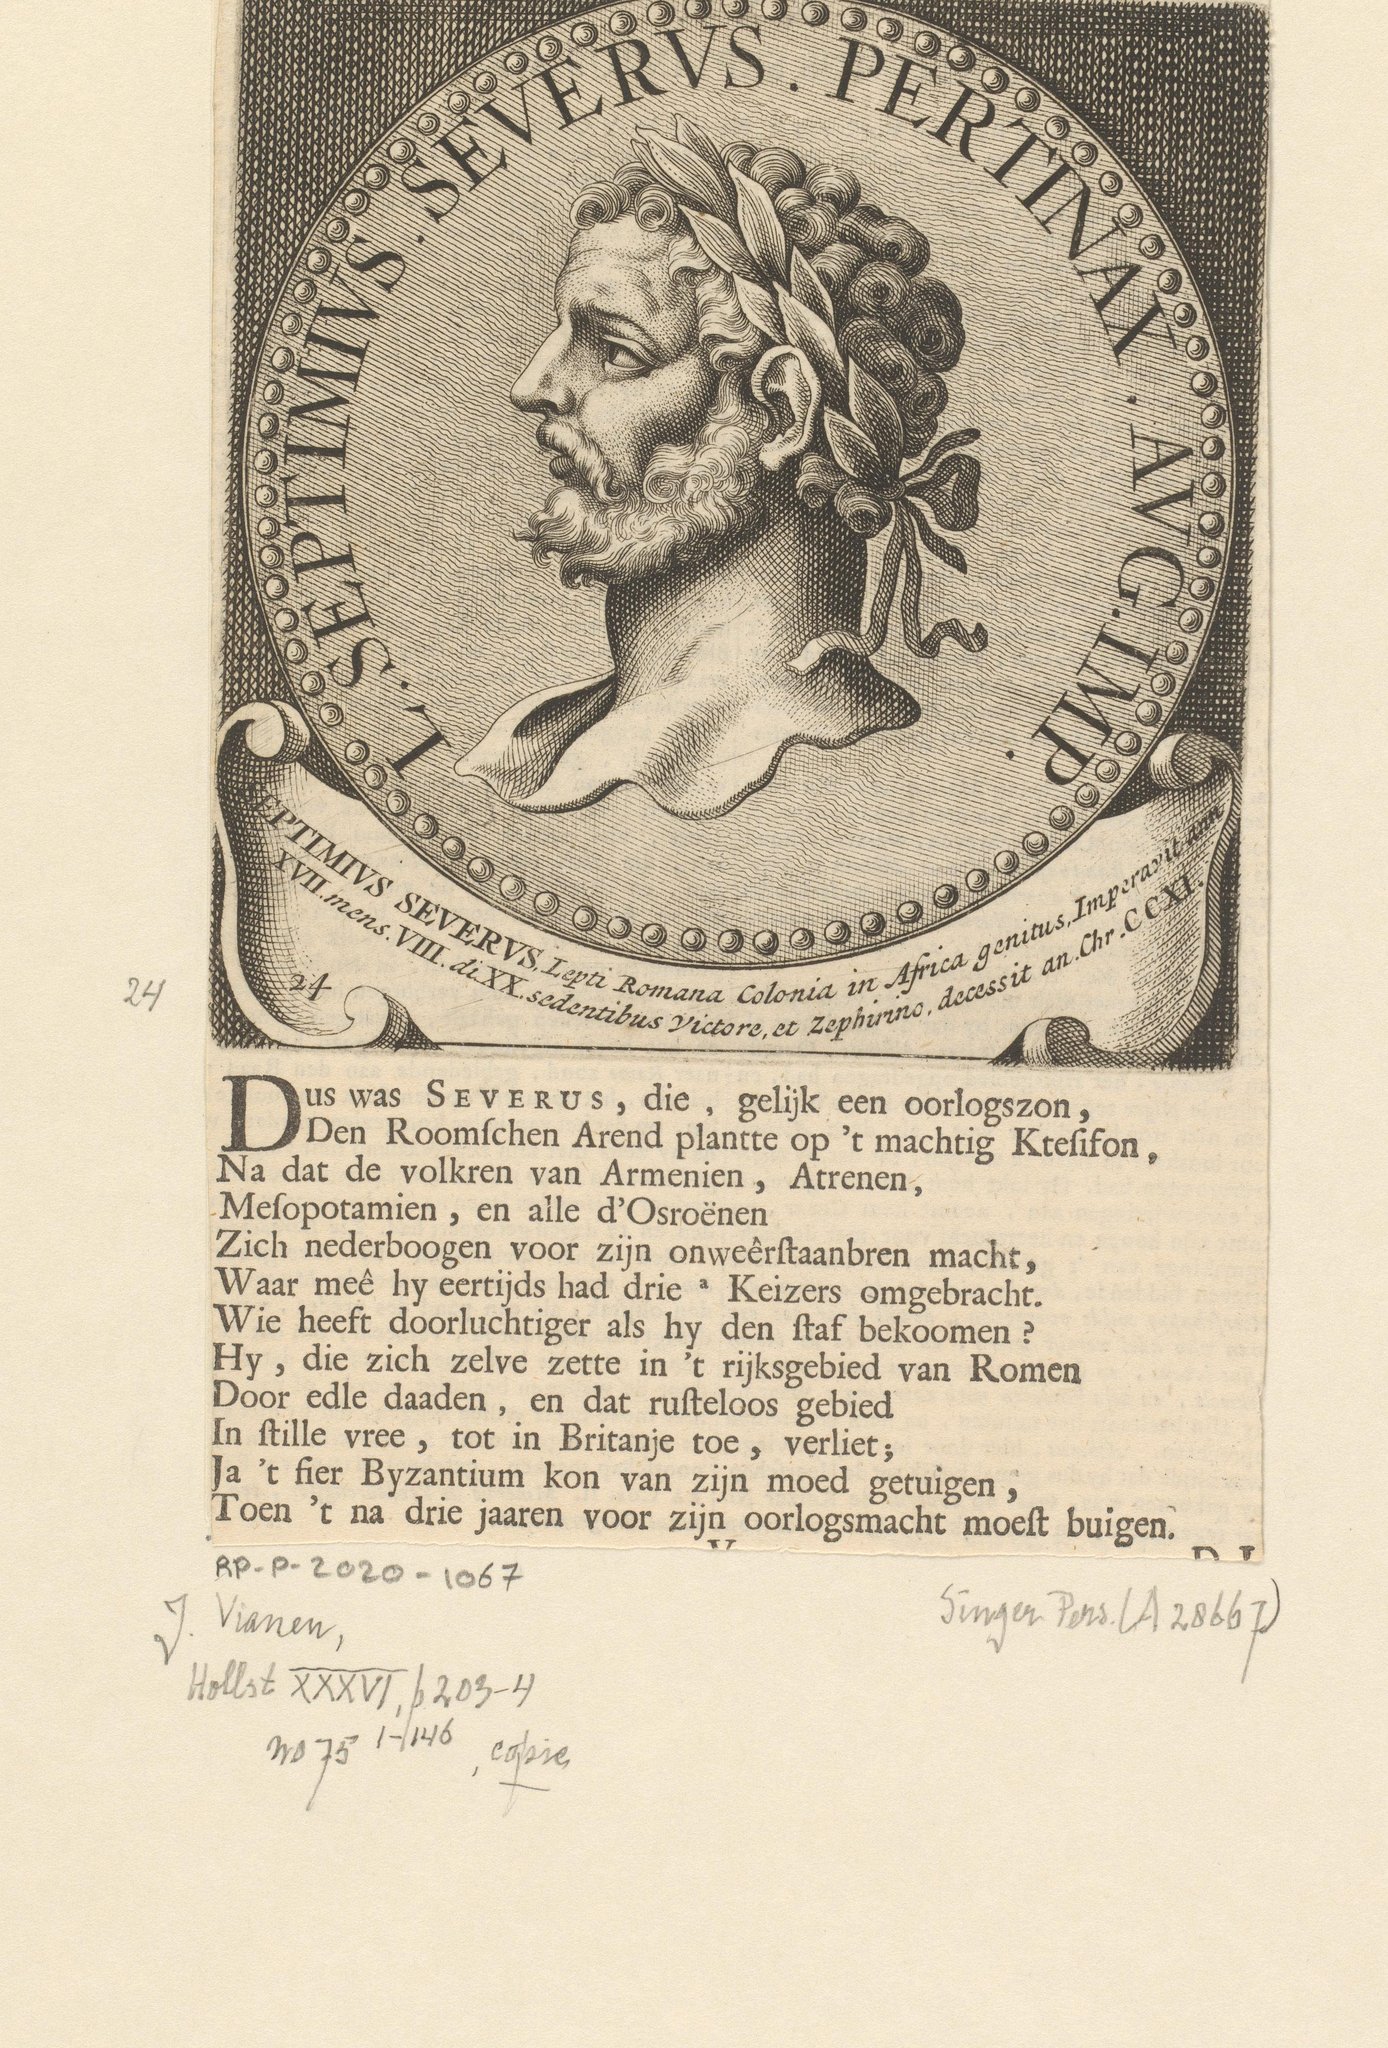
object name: book illustration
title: Portret van keizer Septimius Severus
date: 1697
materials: paper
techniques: engraving, etching, letterpress printing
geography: utrecht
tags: historical persons, emperor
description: Prent uit: Bogaert, Abraham. De Roomsche monarchy, vertoont in de muntbeelden der westersche en oostersche keizeren (...). Utrecht: François Halma en Willem van de Water, 1697, p. 155. Eerste staat verschenen in een grotere prent met twaalf portretten, gedateerd 1695.